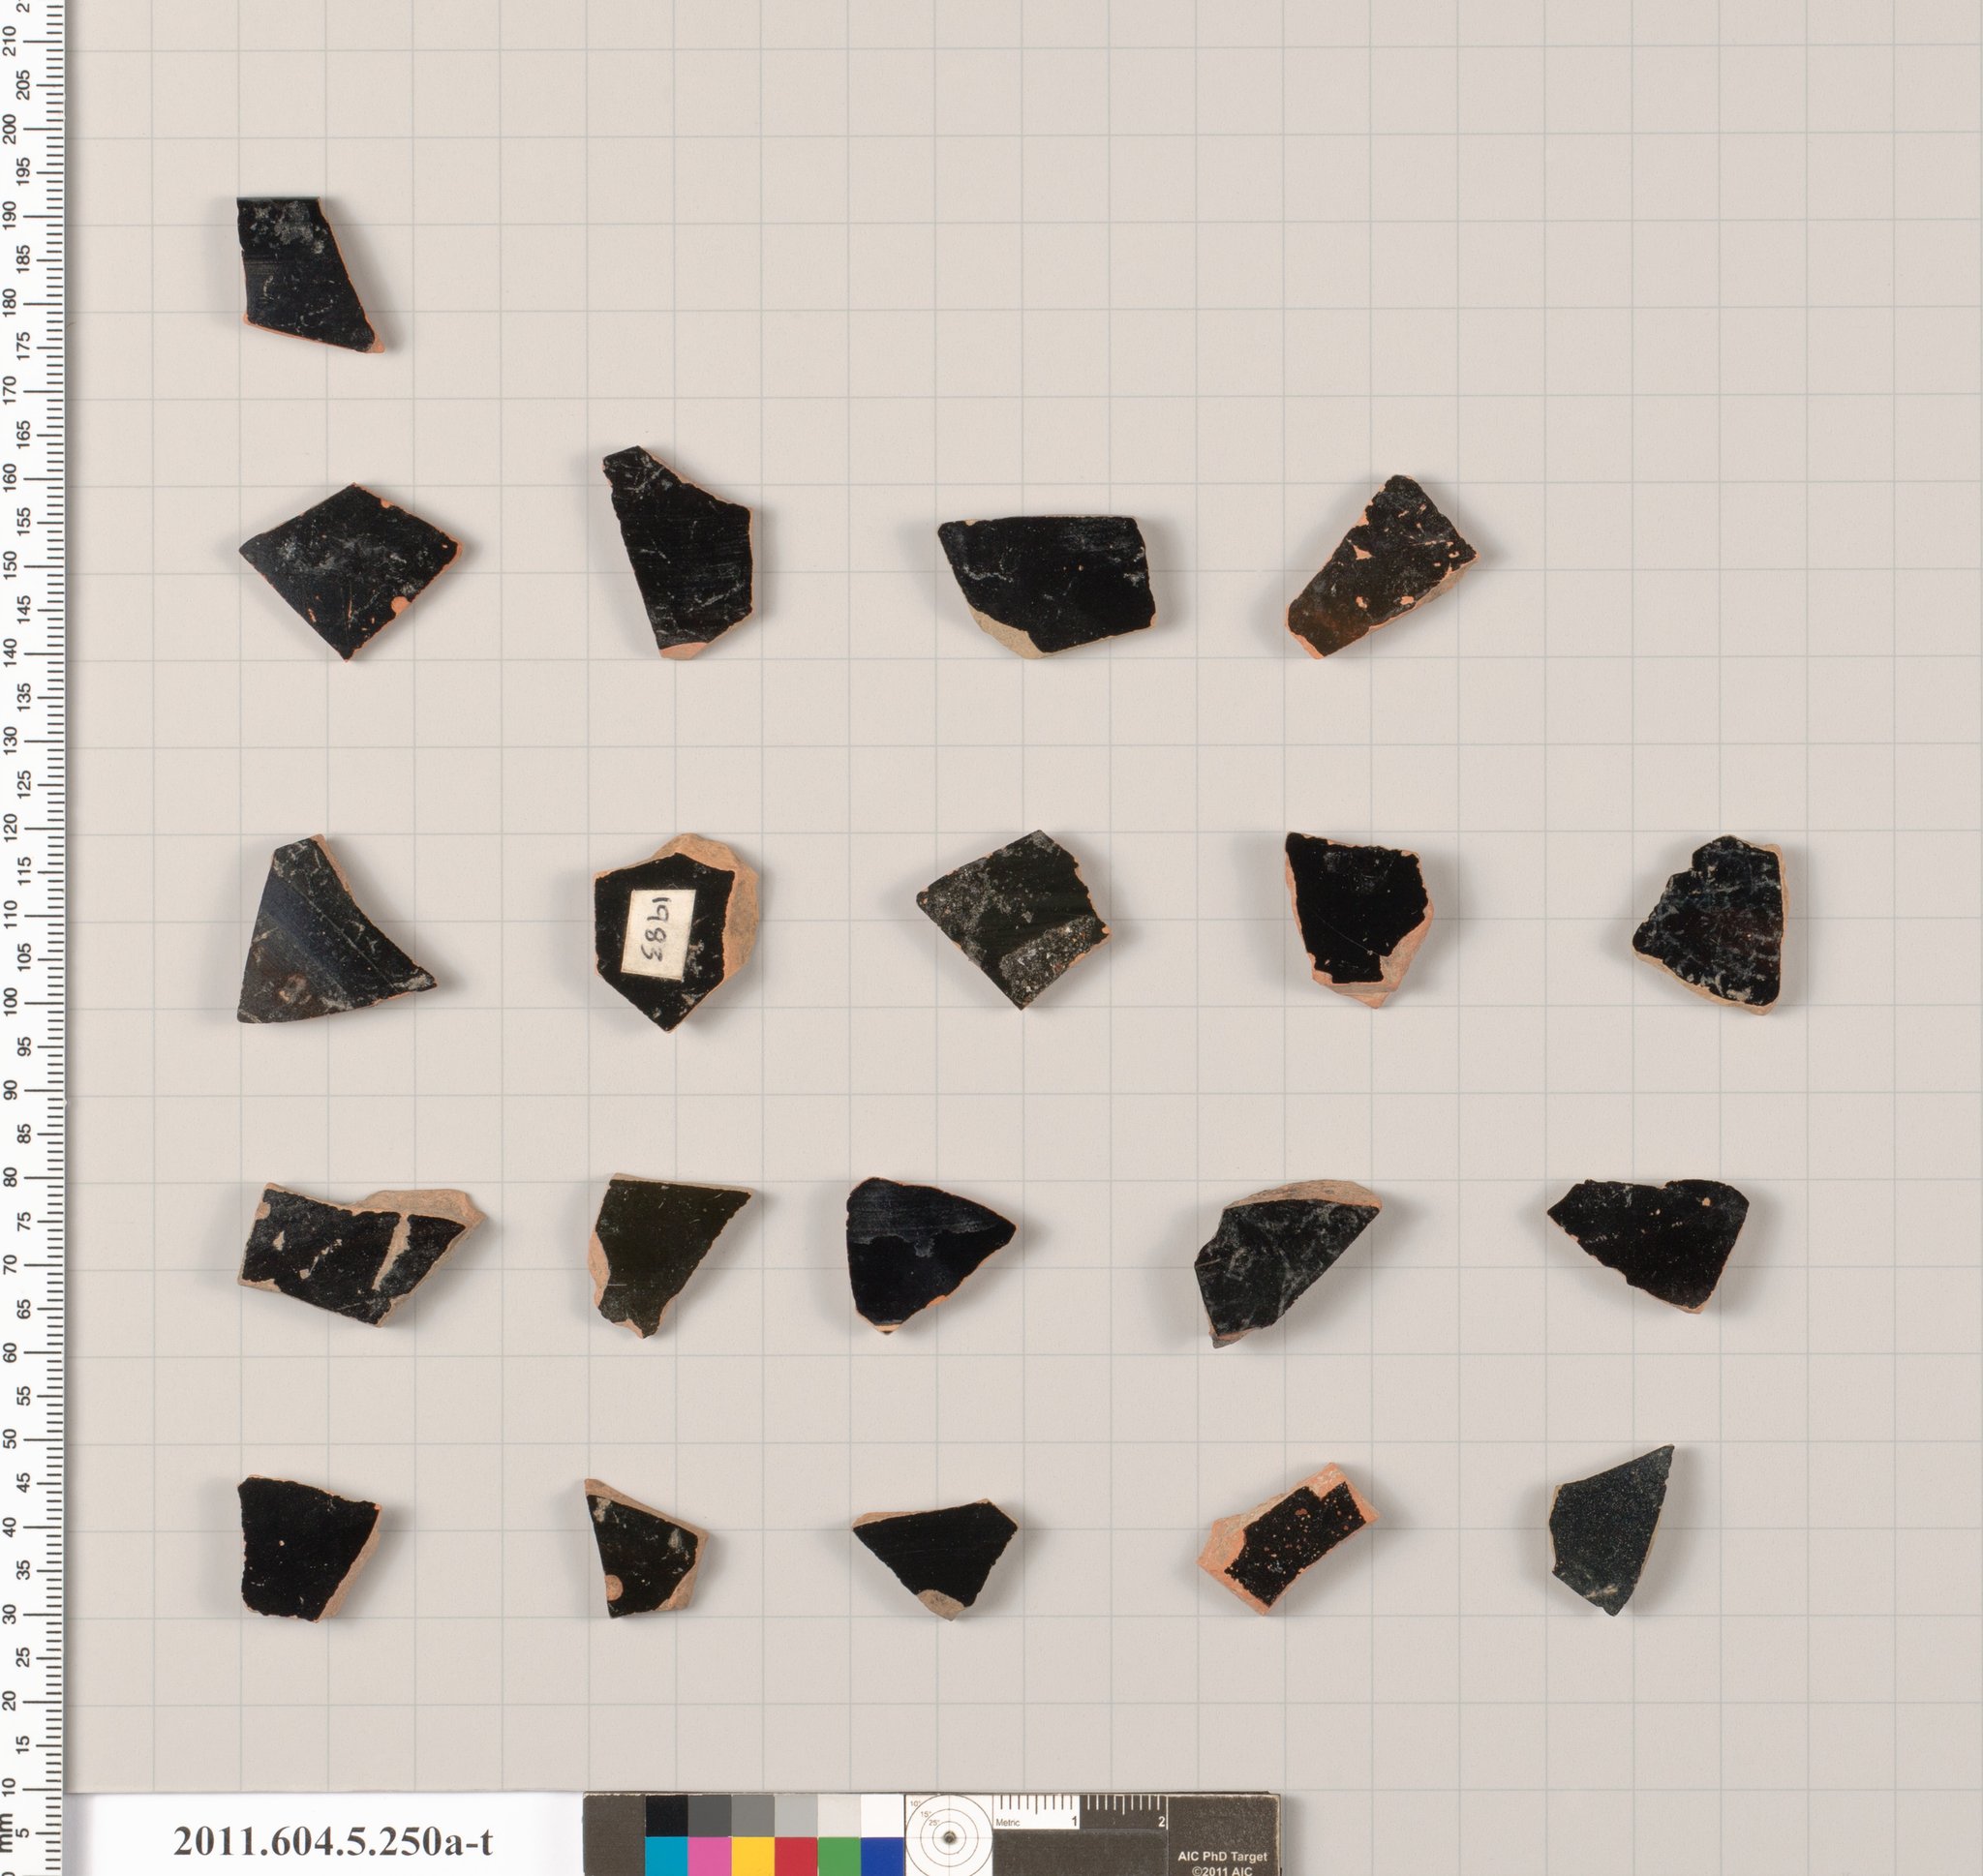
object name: kylix fragment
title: Terracotta fragments of kylikes (drinking cups)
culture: greek, attic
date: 600-401 BCE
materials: terracotta